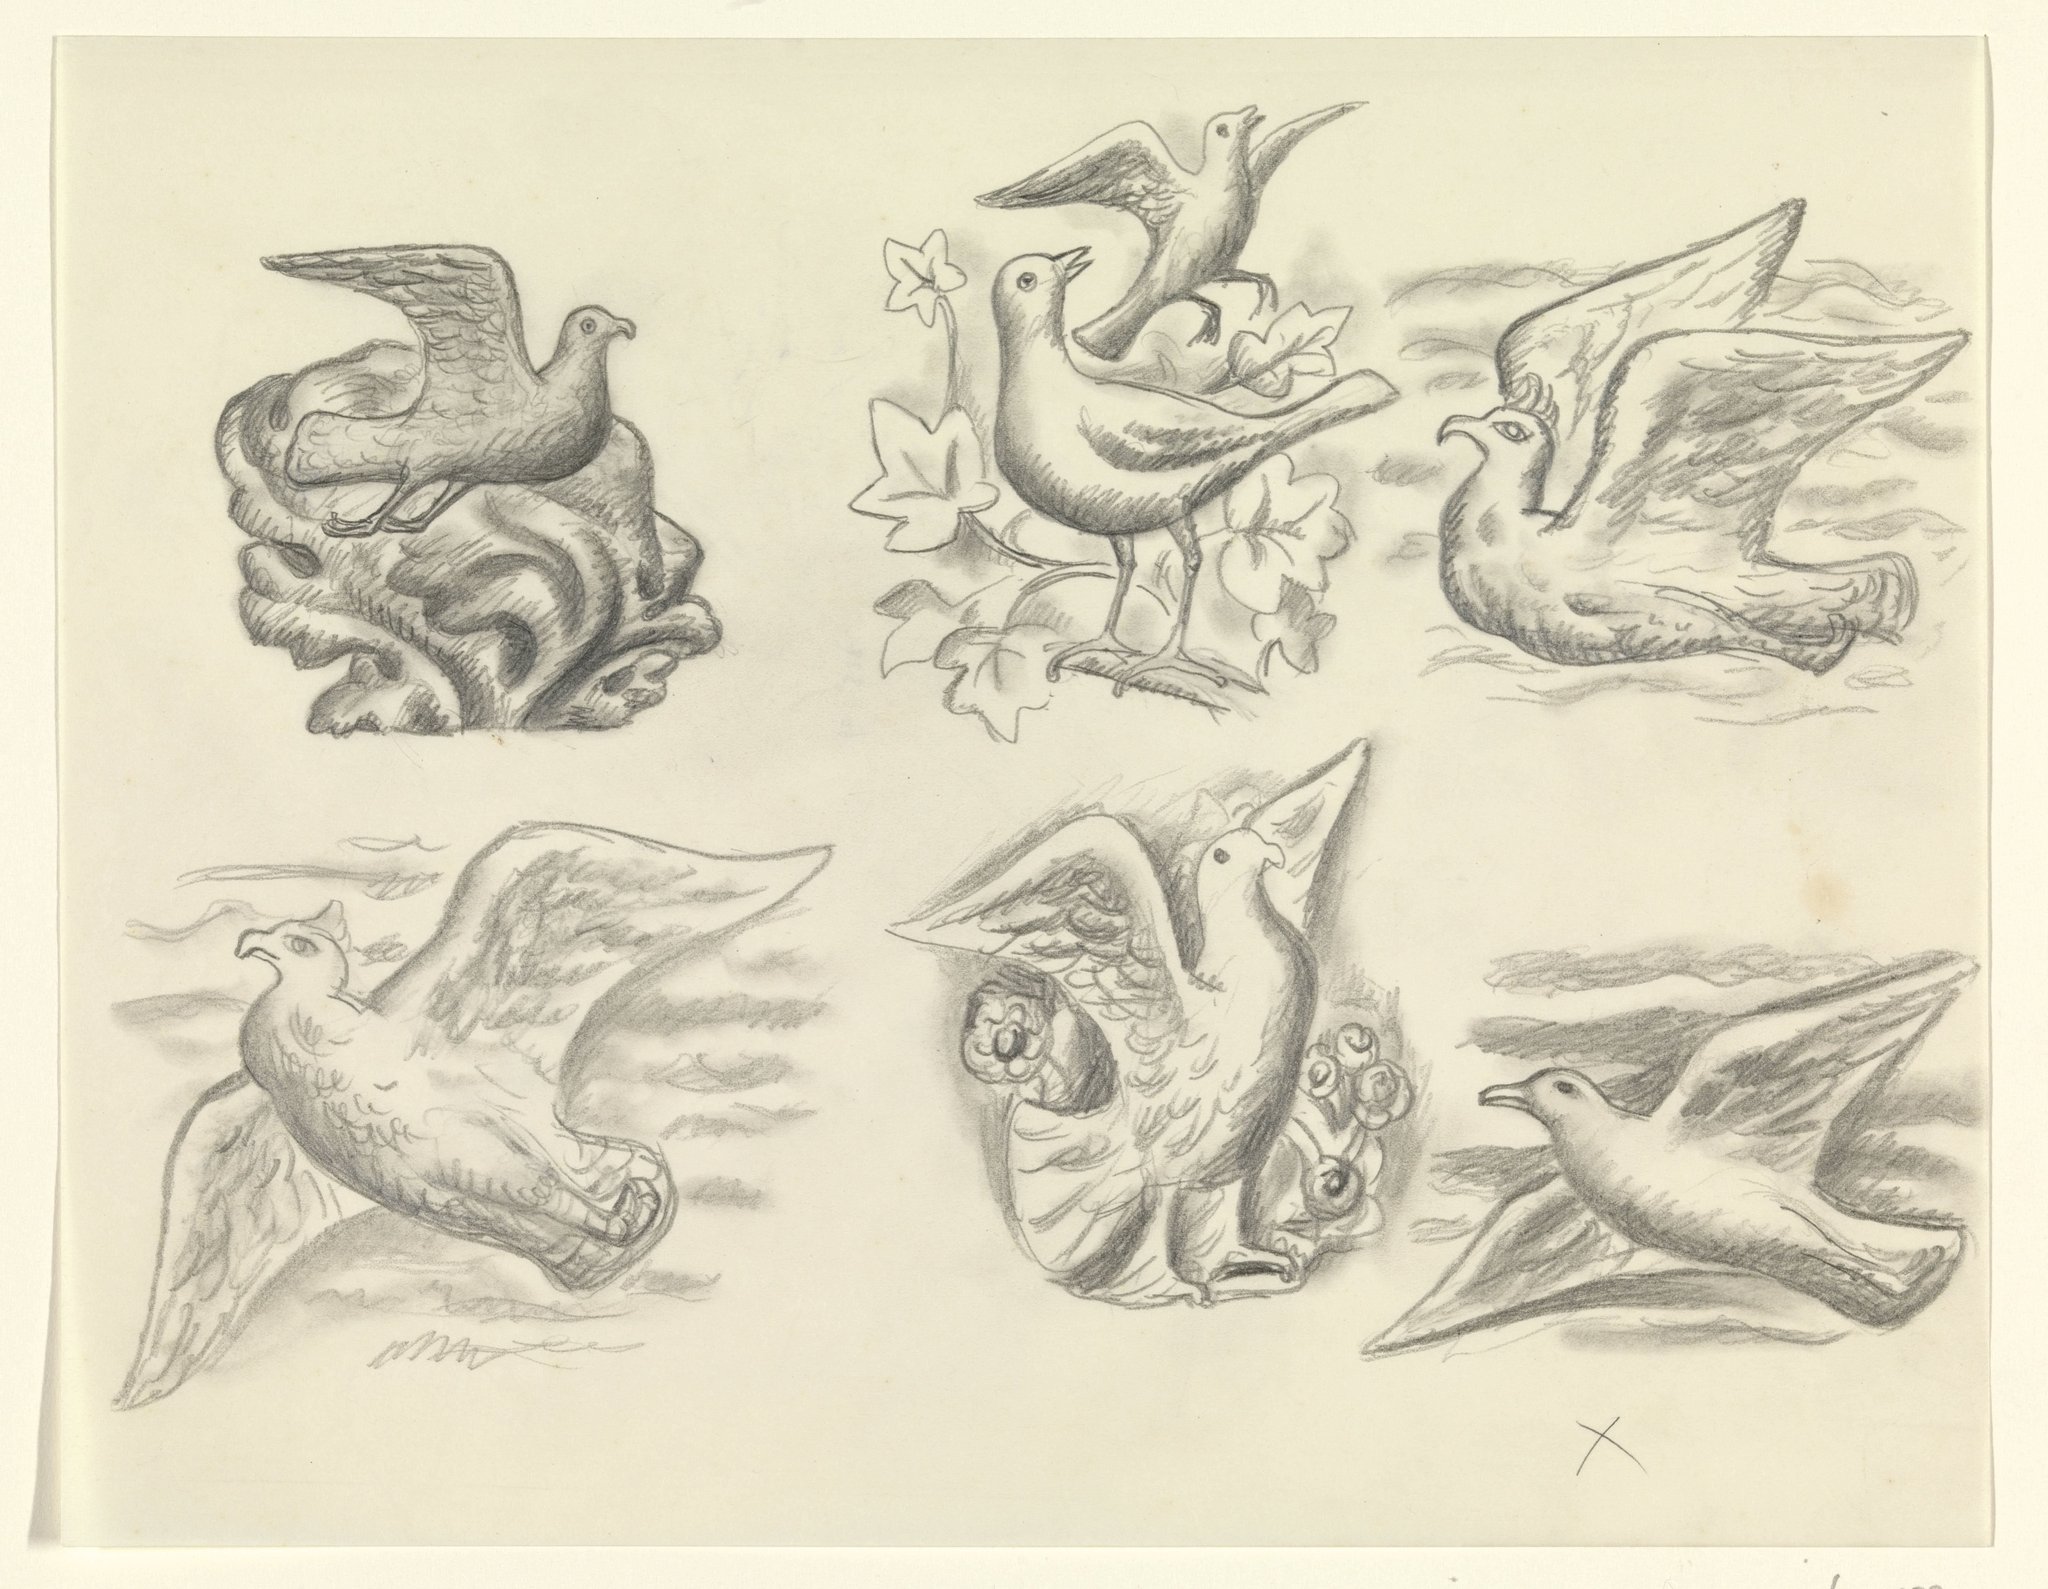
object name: drawing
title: Zeven duiven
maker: leo gestel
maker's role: draughtsman, print maker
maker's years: 1881-1941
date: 1939-1941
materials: paper, pencil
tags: trees, flying, doves, pigeons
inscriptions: collector's mark: Lugt 2228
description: Ontwerp voor een watermerk voor een bankbiljet.